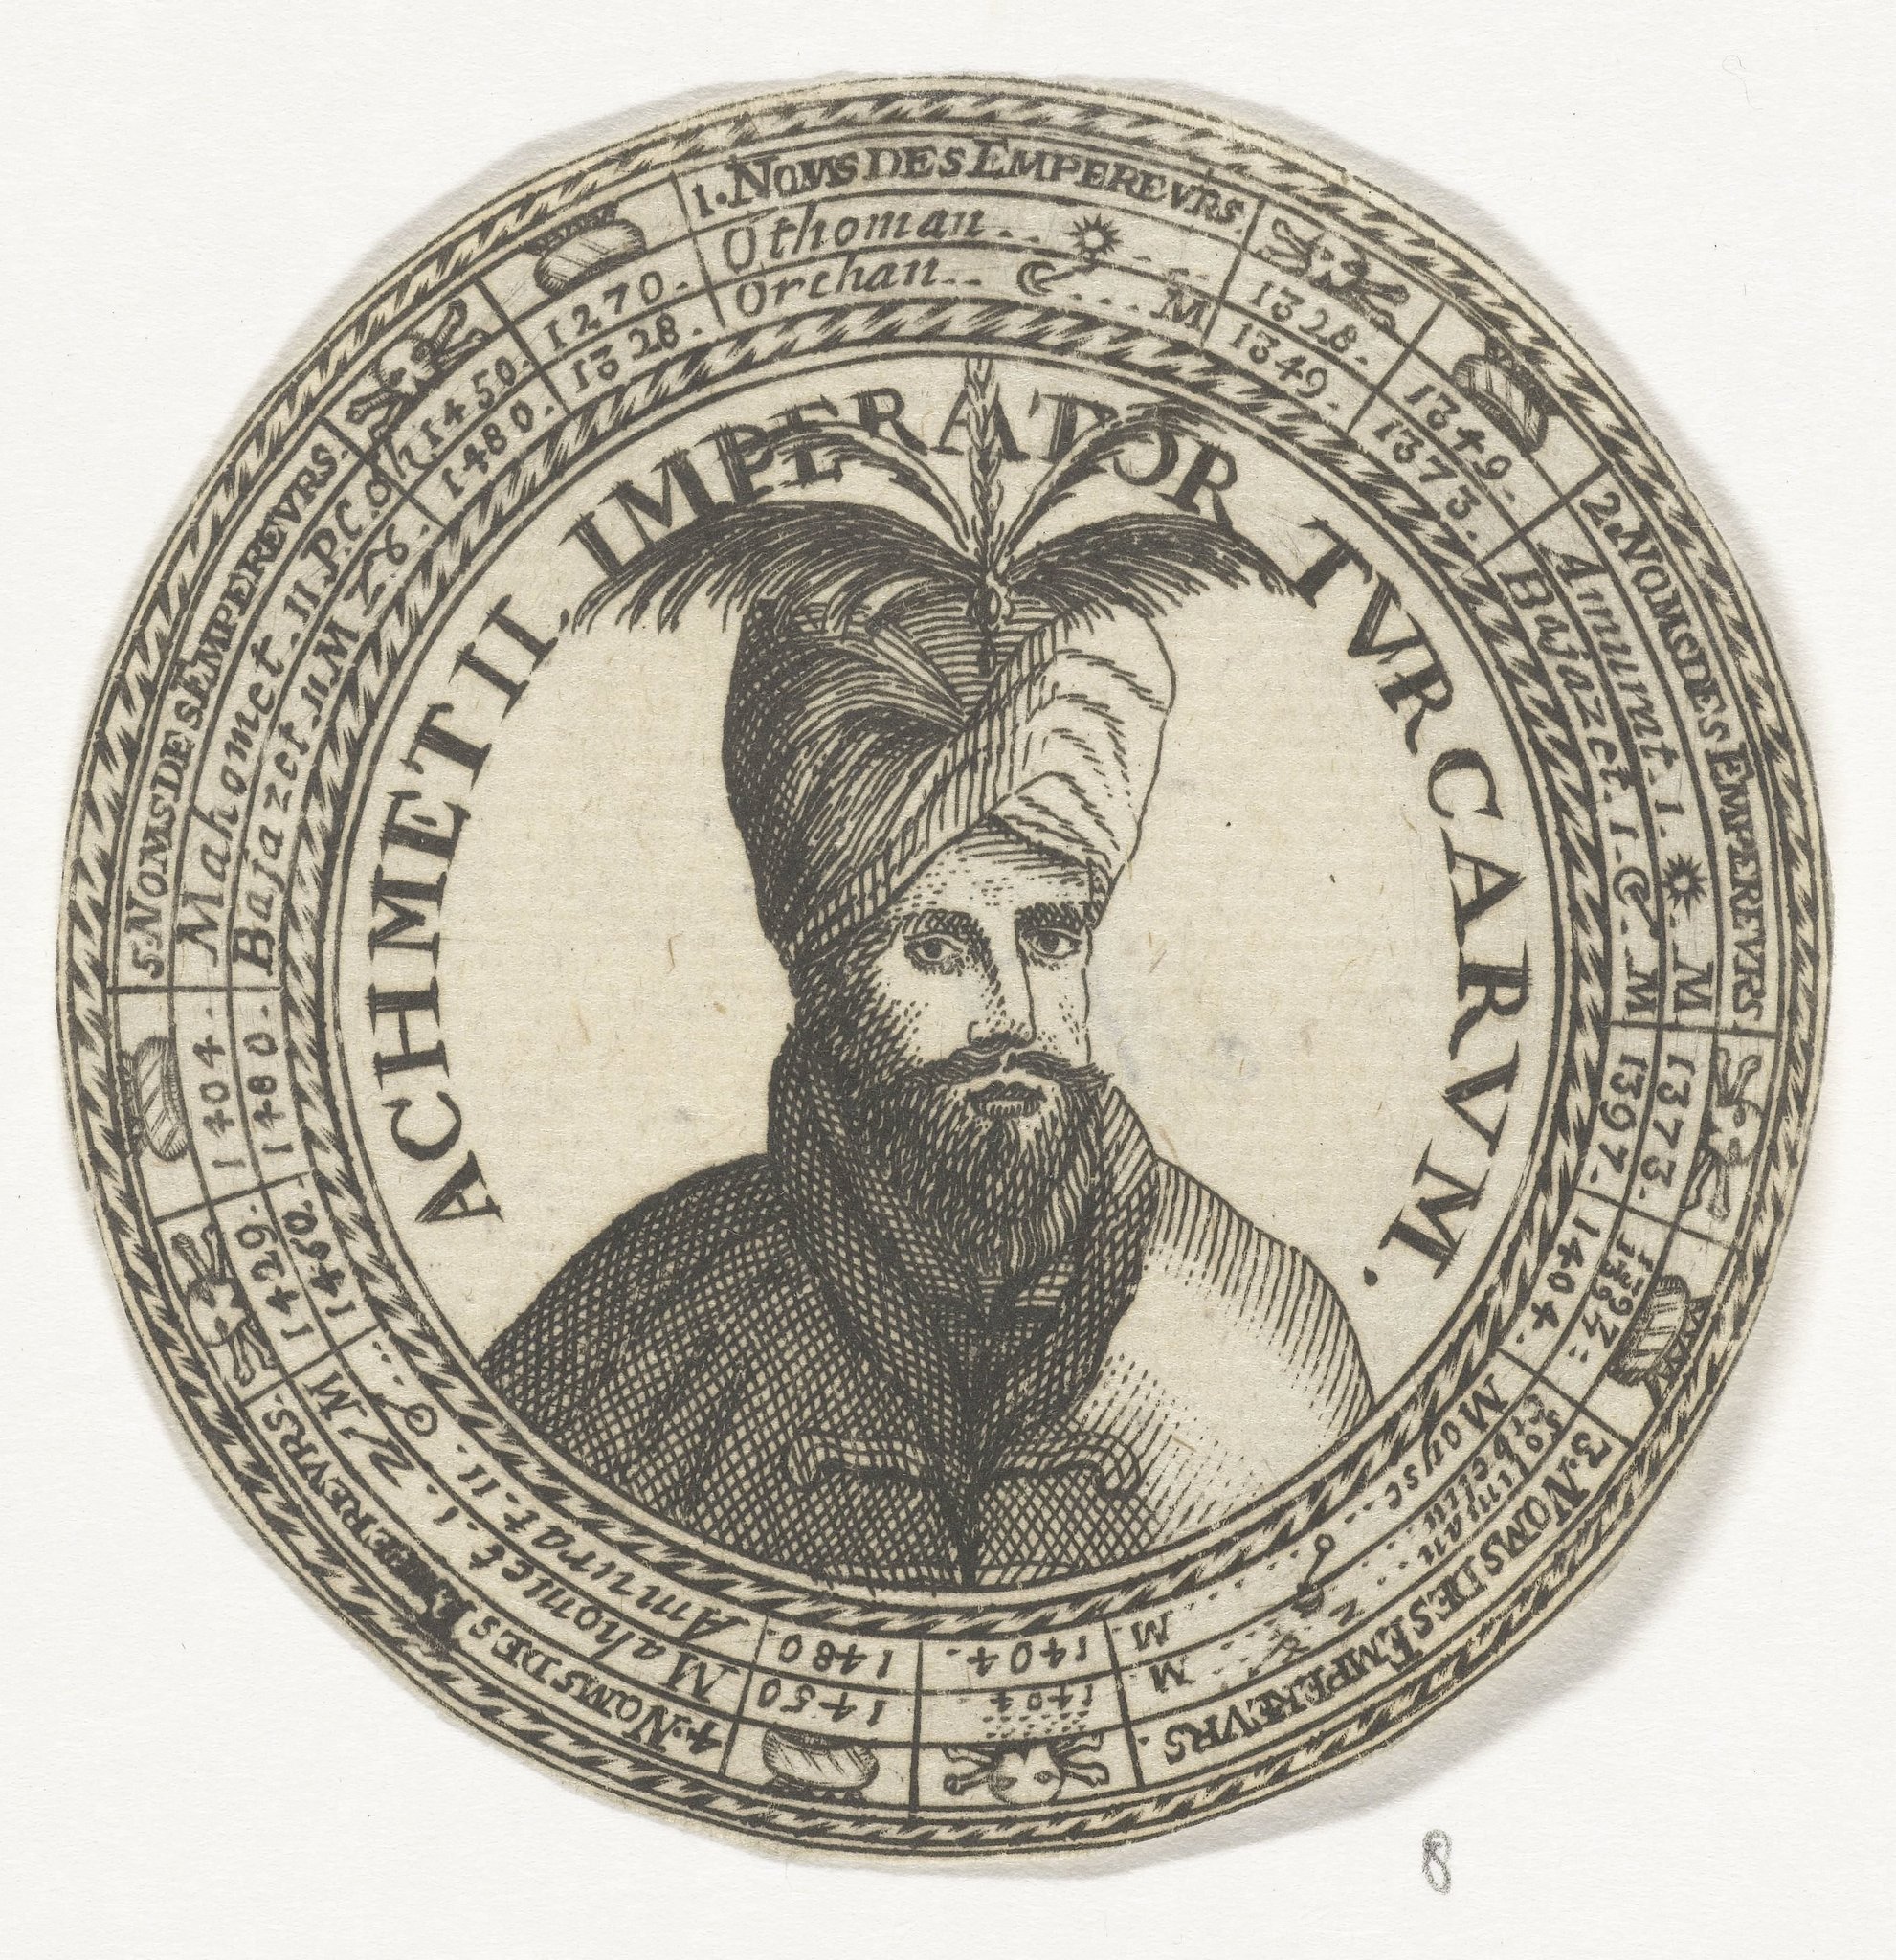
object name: print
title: Penning met het portret van Ahmed III en met de namen van de Ottomaanse sultans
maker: Anonymous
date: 1708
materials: paper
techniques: etching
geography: amsterdam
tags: seal (symbol of sovereignty), other sovereign (with title)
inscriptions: number: ‘9’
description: Ontwerp van een ronde penning met, in drie concentrische cirkels, de namen van Ottomaanse sultans en hun regeringsjaren, beginnende bij sultan Osman I en eindigend bij Mehmet II . In het midden van de penning het portret van keizer Ahmed II.